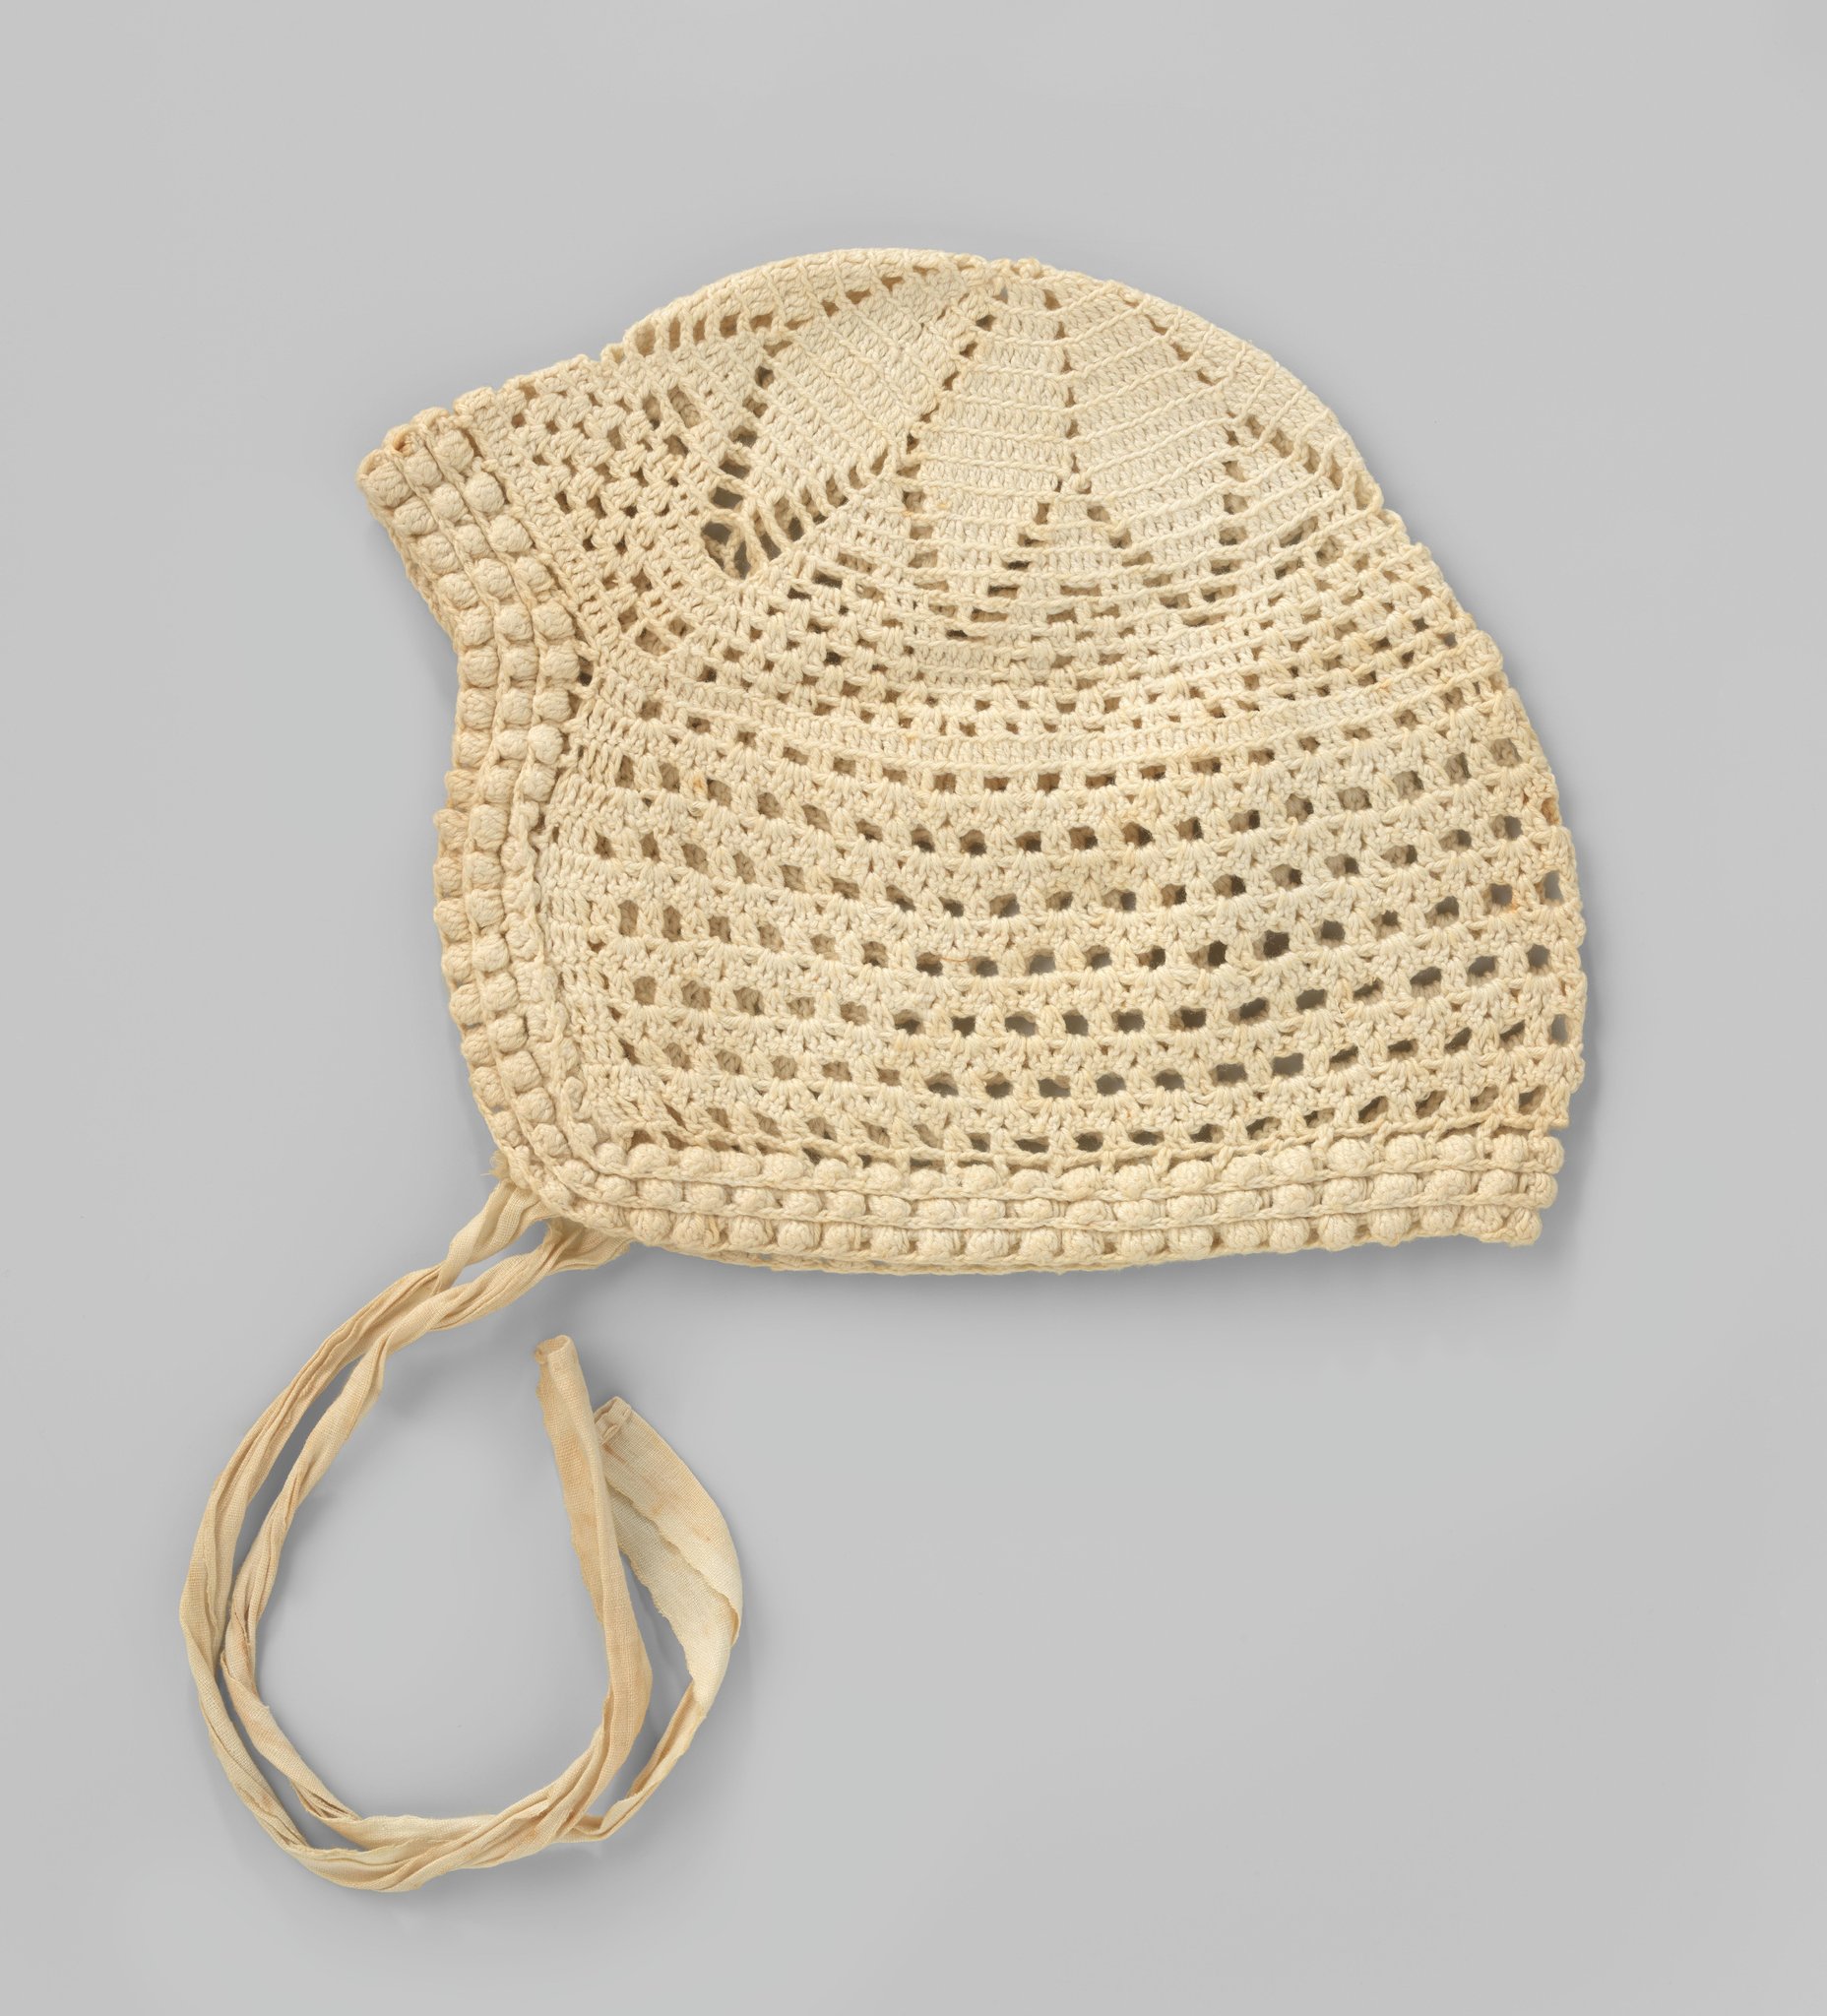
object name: childrenswear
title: Gehaakte kindermuts van wit katoen, met ajoursteek en een buitenrand, bestaand uit drie bolranden; achterop een bloemmotief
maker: Anonymous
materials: cotton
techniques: crochet, embroidery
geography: europe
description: Gehaakte kindermuts van wit katoen, met ajoursteek en een buitenrand, bestaand uit drie bolranden; achterop een bloemmotief.